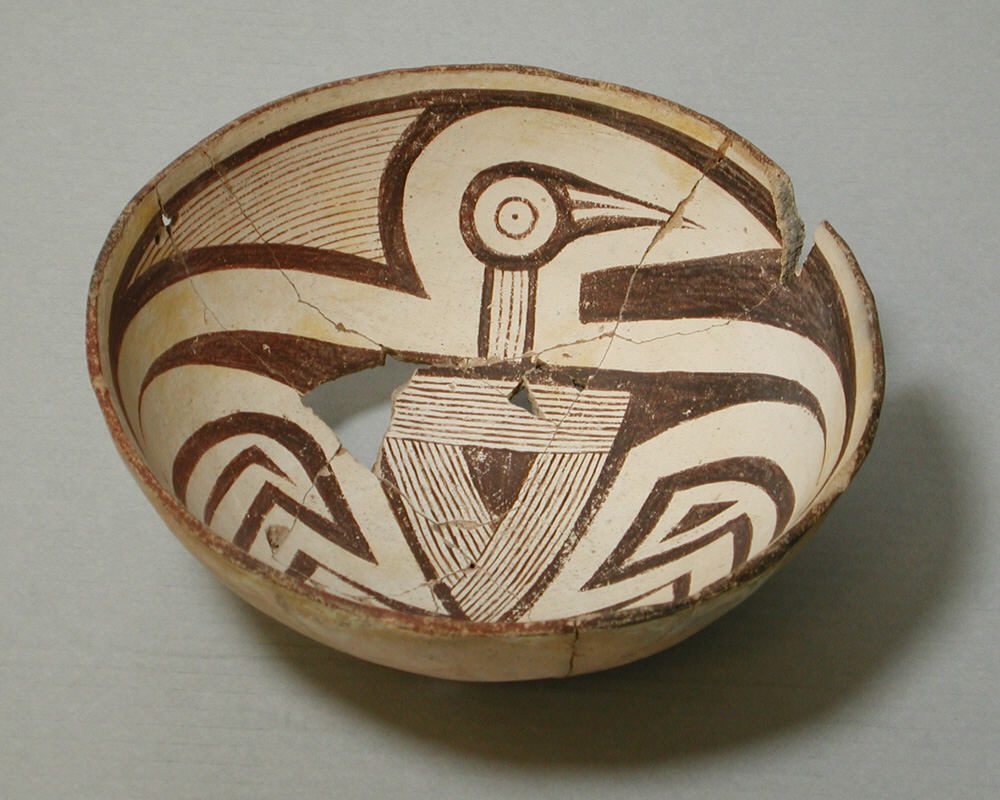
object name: bowl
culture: mimbres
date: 850-1050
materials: ceramic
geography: united states